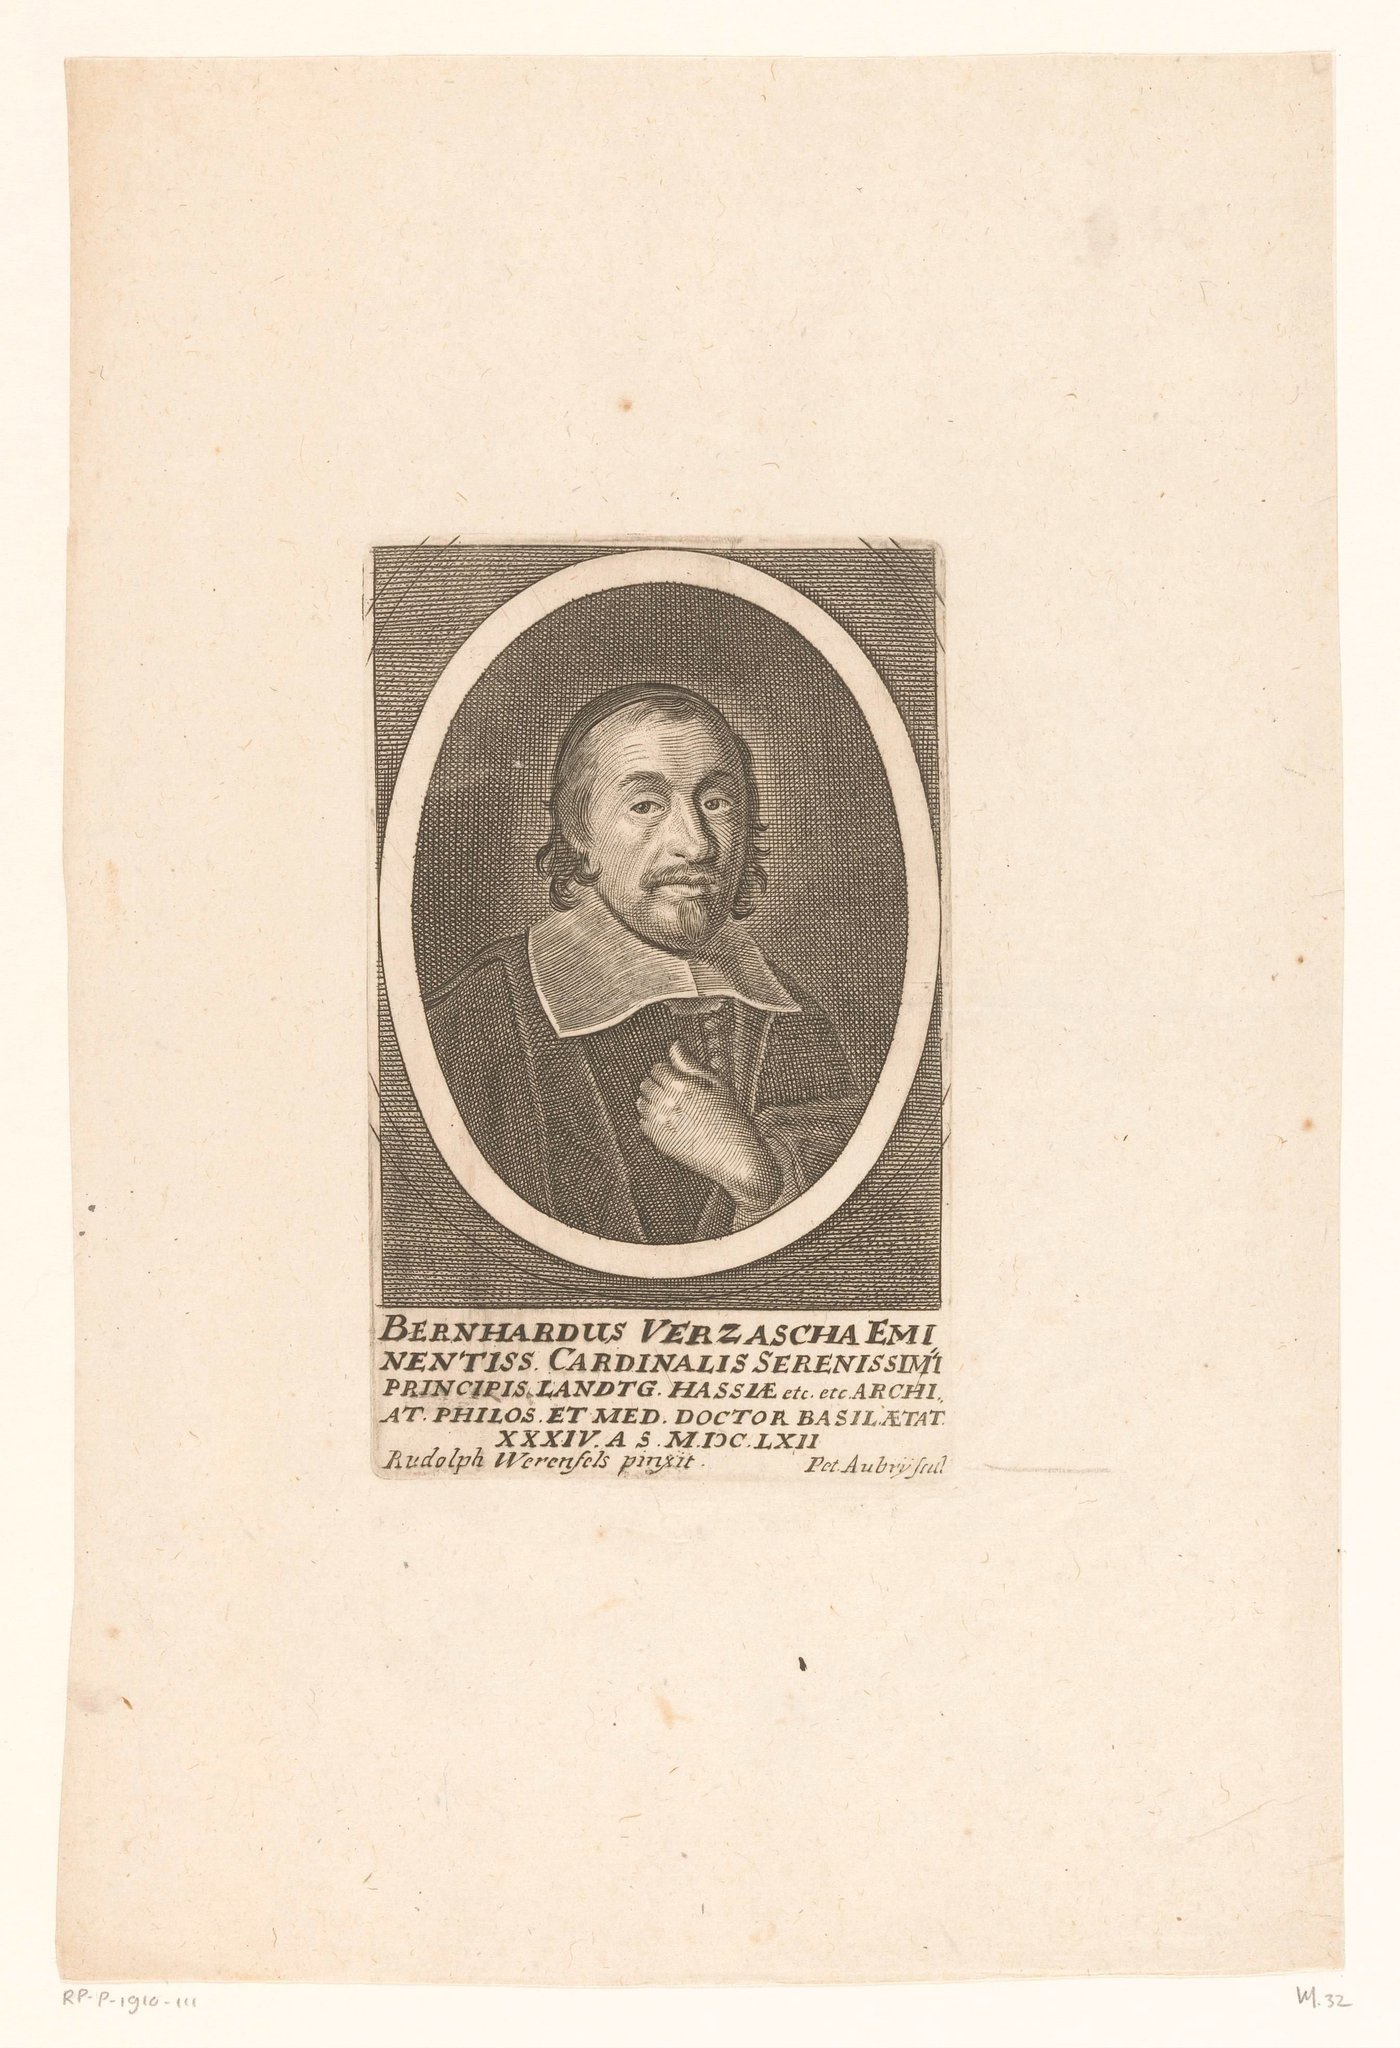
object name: print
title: Portret van Bernard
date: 1662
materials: paper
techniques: engraving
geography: straatsburg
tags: historical persons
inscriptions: collector's mark: Lugt 2228